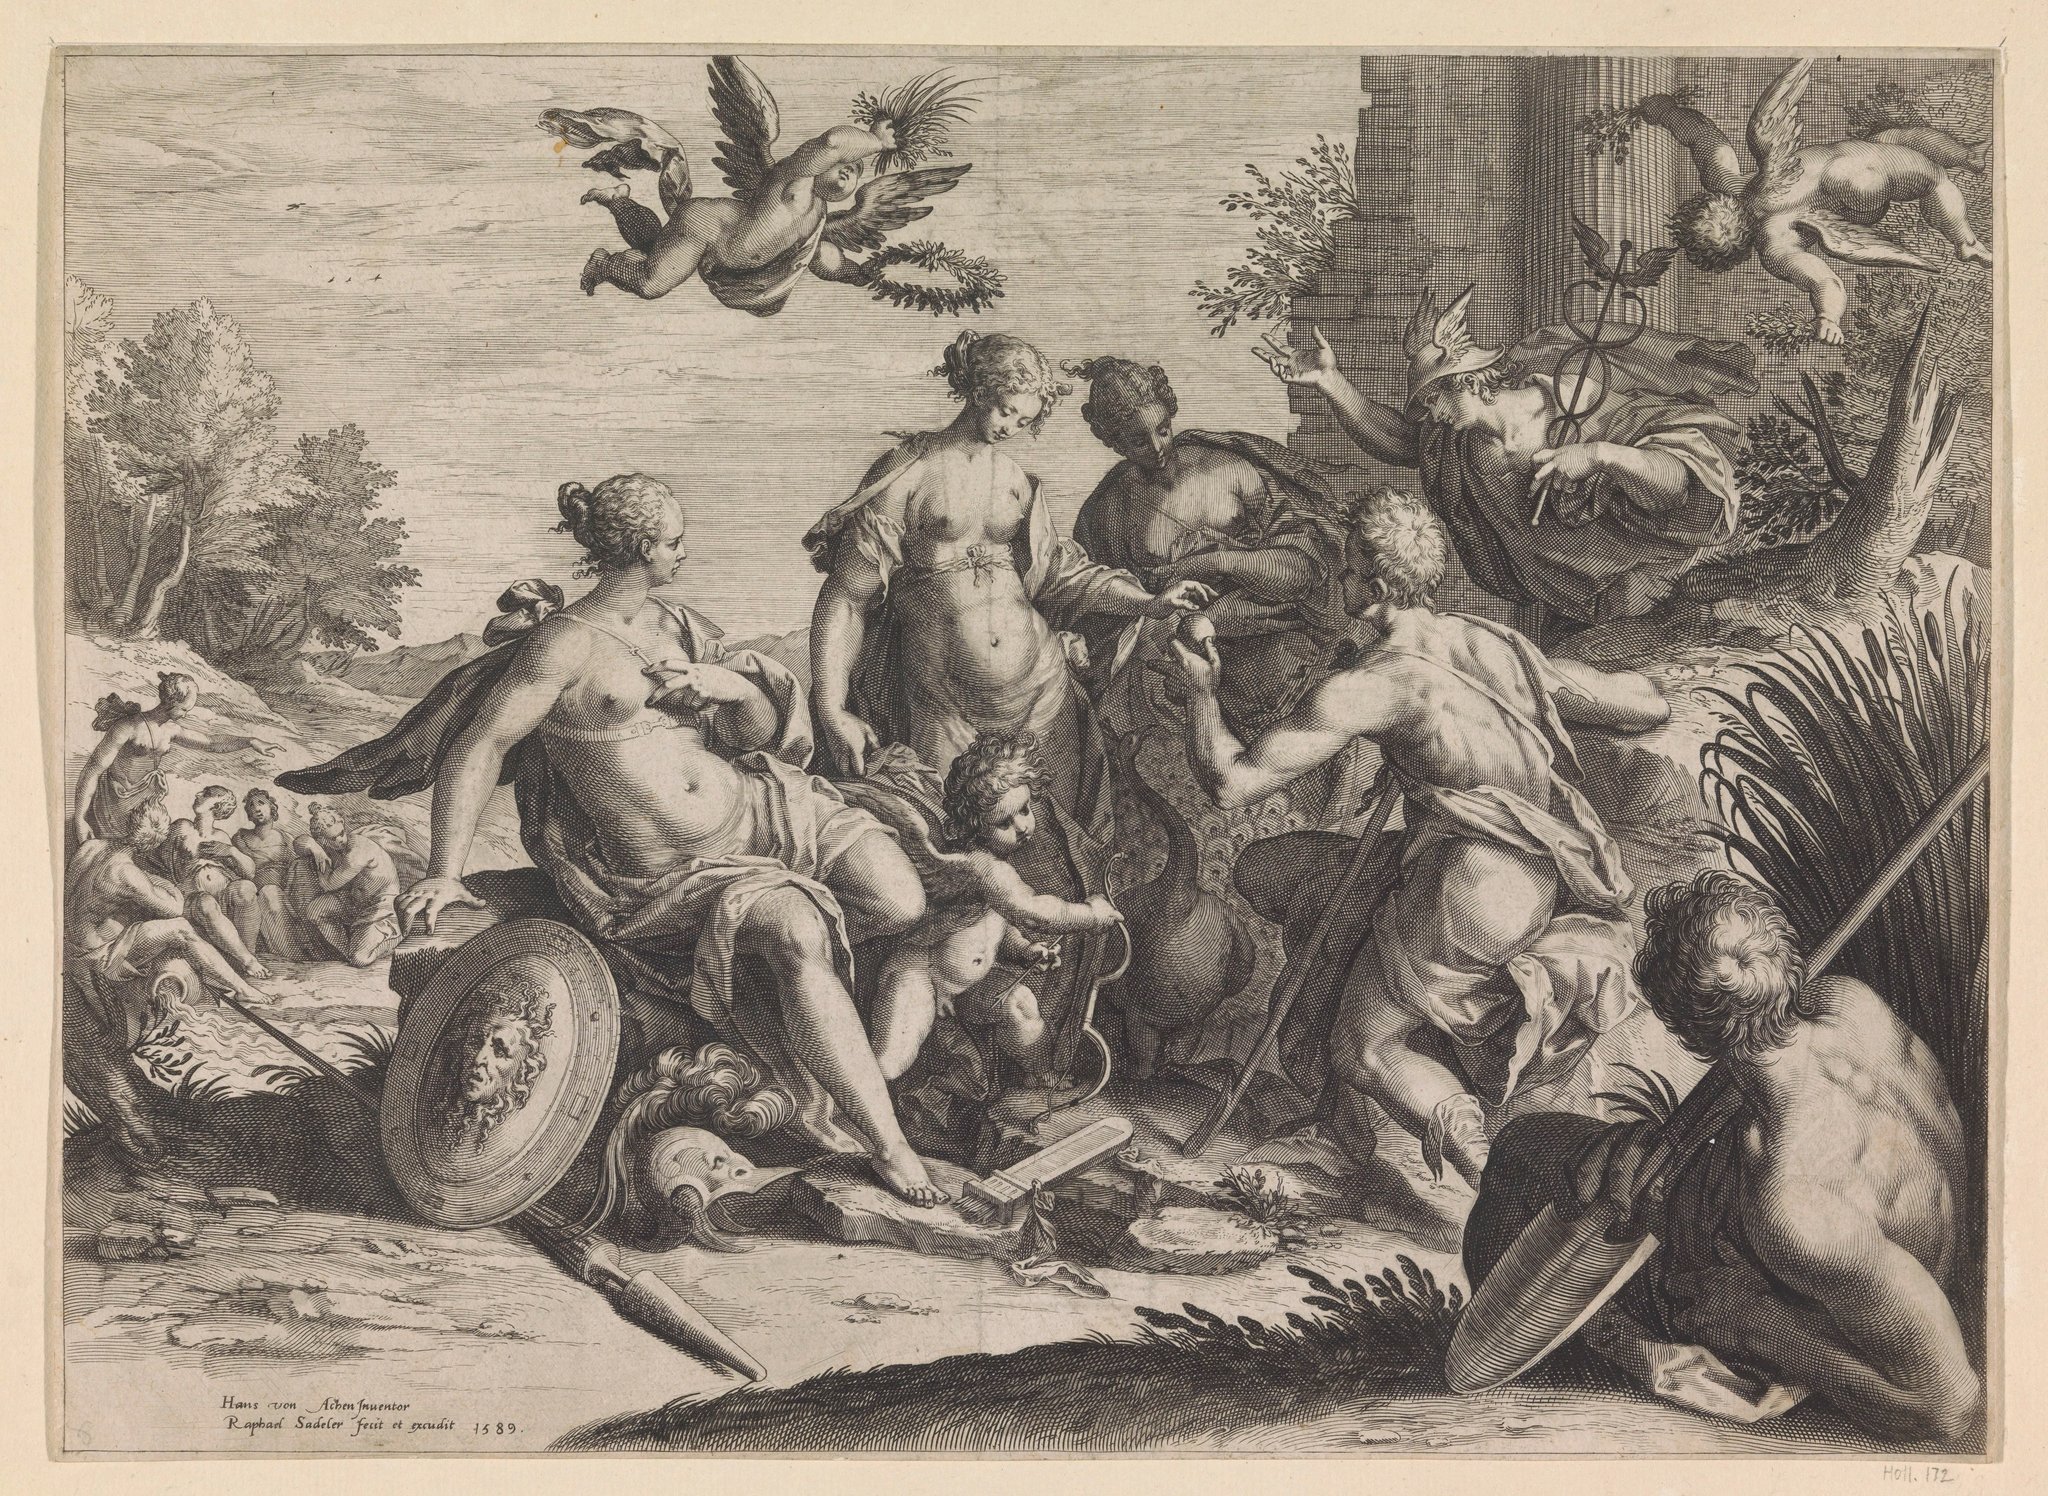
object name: print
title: Oordeel van Paris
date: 1589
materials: paper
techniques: engraving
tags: the judgement of paris (mercury present), cupids: 'amores', 'amoretti', 'putti'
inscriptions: collector's mark: Lugt 240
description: De herder Paris op de voorgrond. Hij moet de drie mooiste godinnen van Olympus beoordelen op hun schoonheid: Juno (rechts, met de pauw), Minerva (links, met schild, helm en lans) en Venus (vergezeld van Amor). Hij geeft de gouden appel aan Venus. Mercurius staat naast Paris. Op de achtergrond enkele riviergoden. In de lucht twee putti.